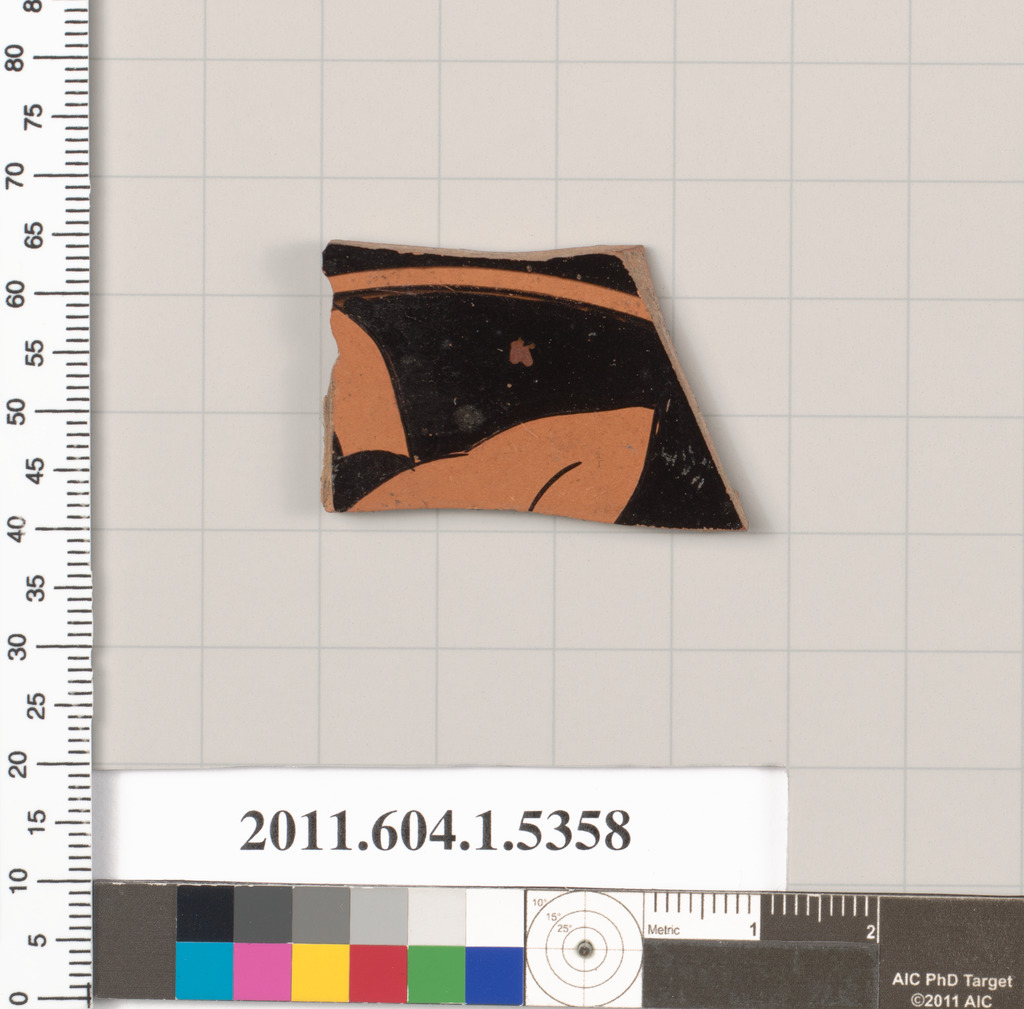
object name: kylix fragment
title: Terracotta fragment of a kylix (drinking cup)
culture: greek, attic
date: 500-490 BCE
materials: terracotta